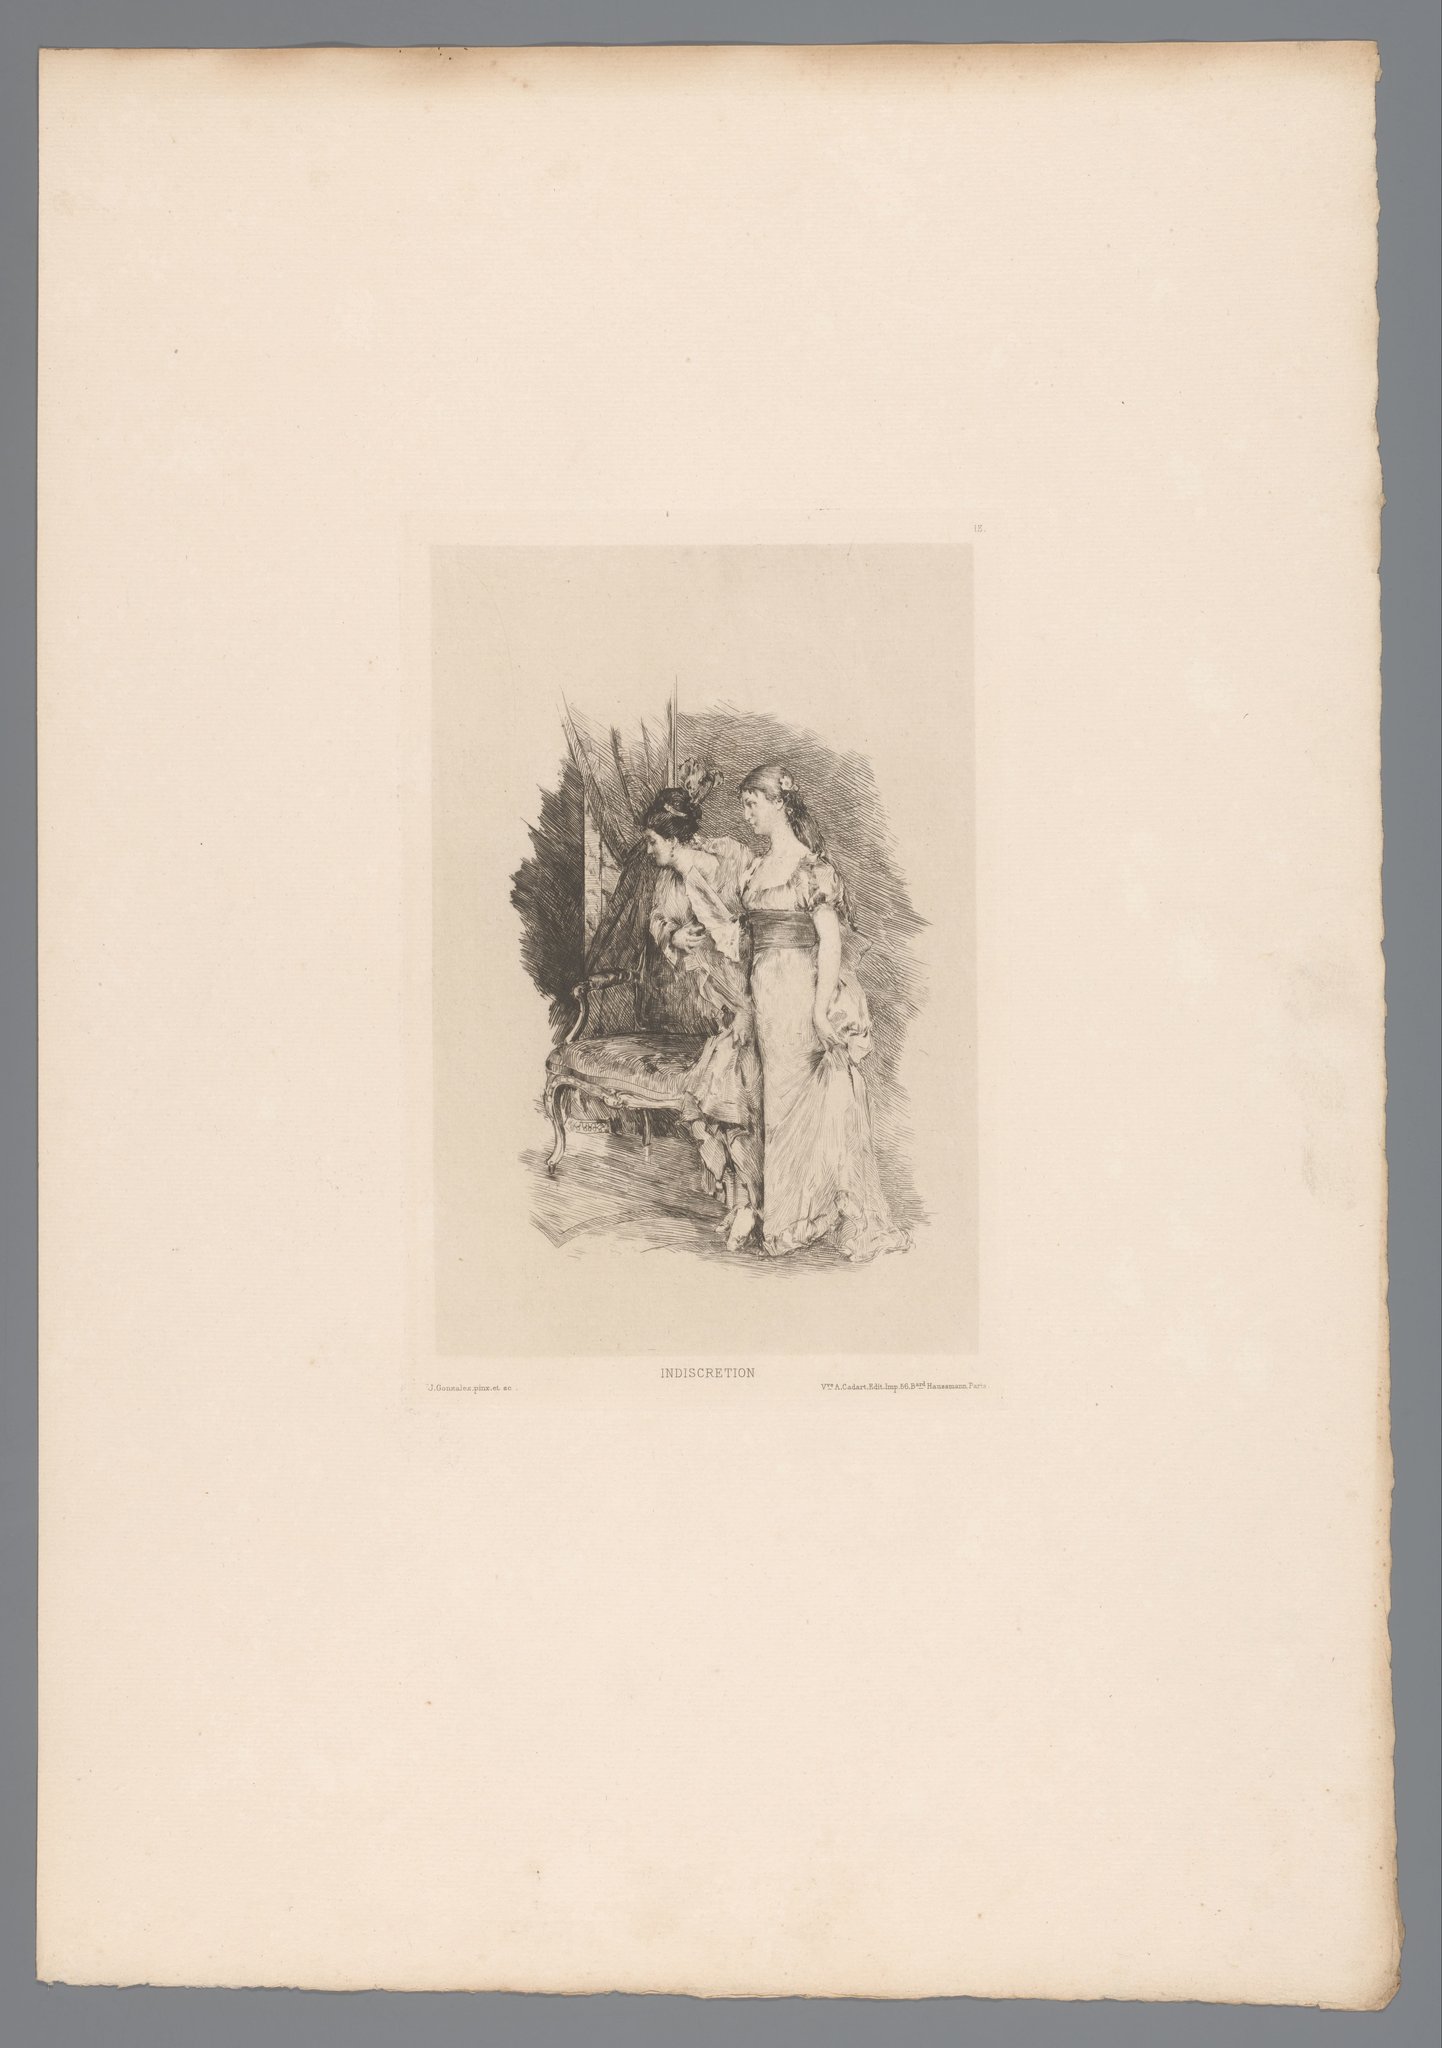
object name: print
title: L'eau-forte en 1881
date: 1881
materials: paper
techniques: drypoint, etching, intaglio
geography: paris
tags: adult woman, spying on someone - aa - female human figure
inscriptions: watermark, collector's mark: ‘AFE v S’, collector's mark: Lugt 2228, collector's mark: Lugt 2760